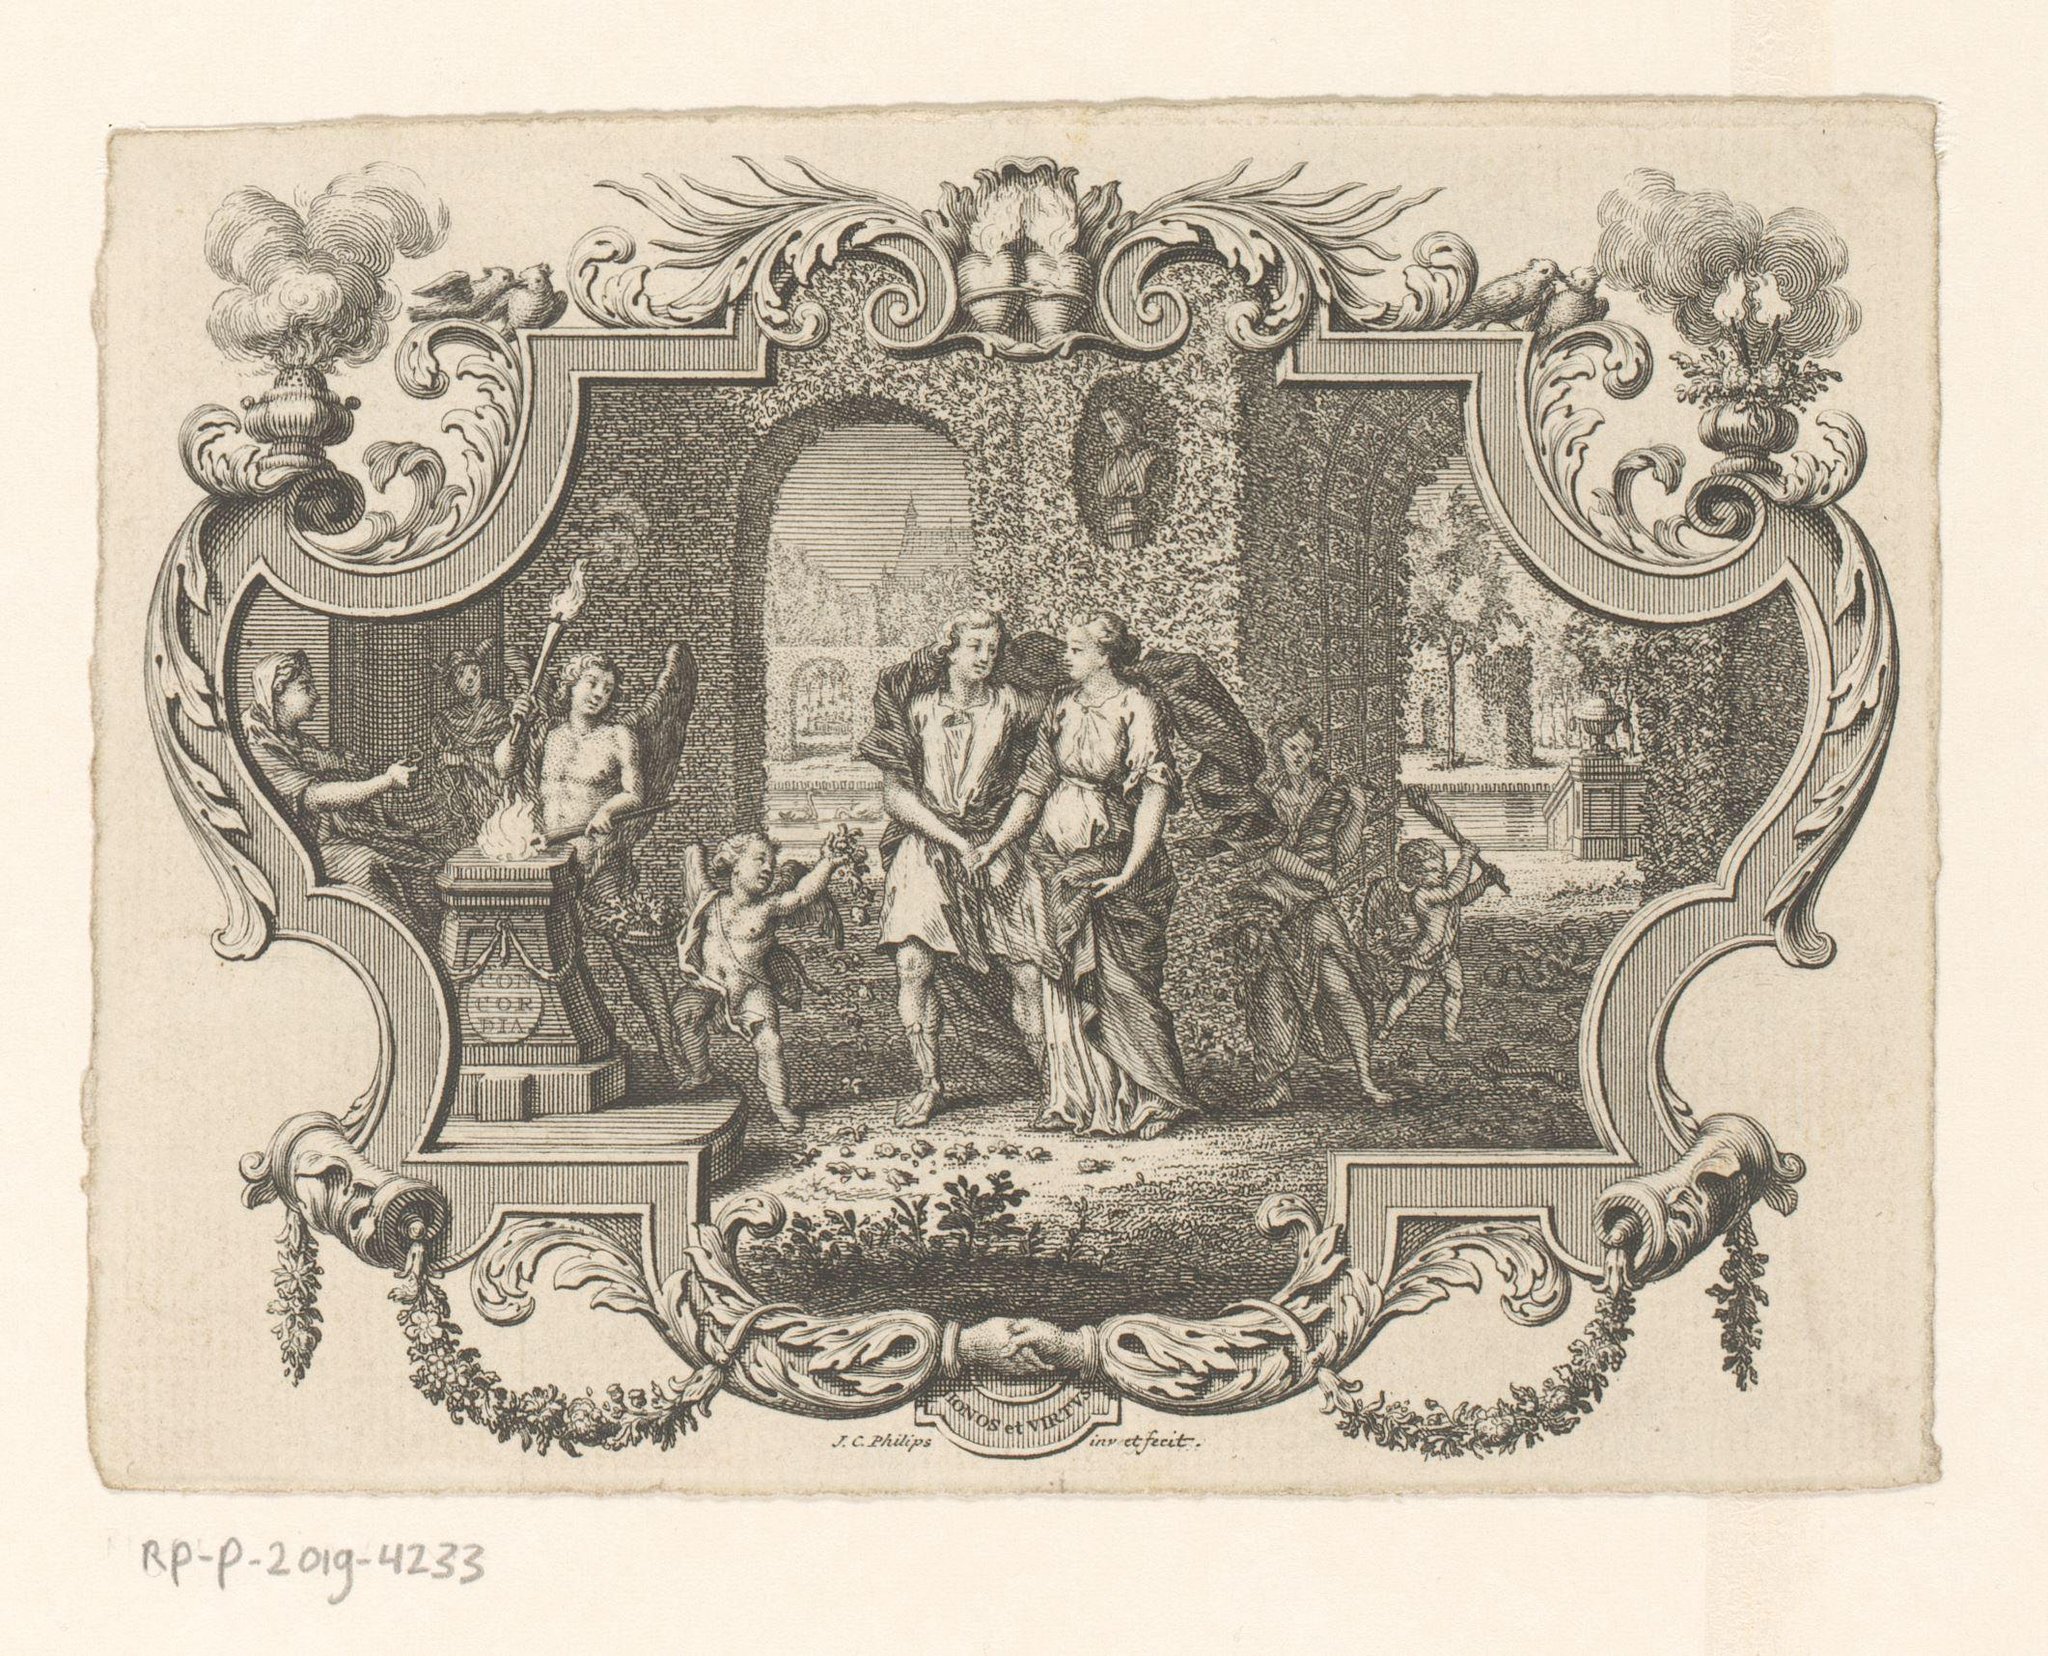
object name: print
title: Eer (Honos) en Dapperheid (Virtus) lopen door een tuin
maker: jan caspar philips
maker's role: draughtsman, print maker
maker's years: 1700-1775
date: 1730-1775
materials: paper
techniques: etching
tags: virtus as roman personification, honos as roman personification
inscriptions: collector's mark: Lugt 2228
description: De Eer en de Dapperheid lopen hand in hand door een Franse tuin. Om hen heen putti en een engel die een toorts houdt bij een vlam, vanaf een pedestal waarop Concordia (Eenheid) staat. Linksachter de engel staat Mercurius.